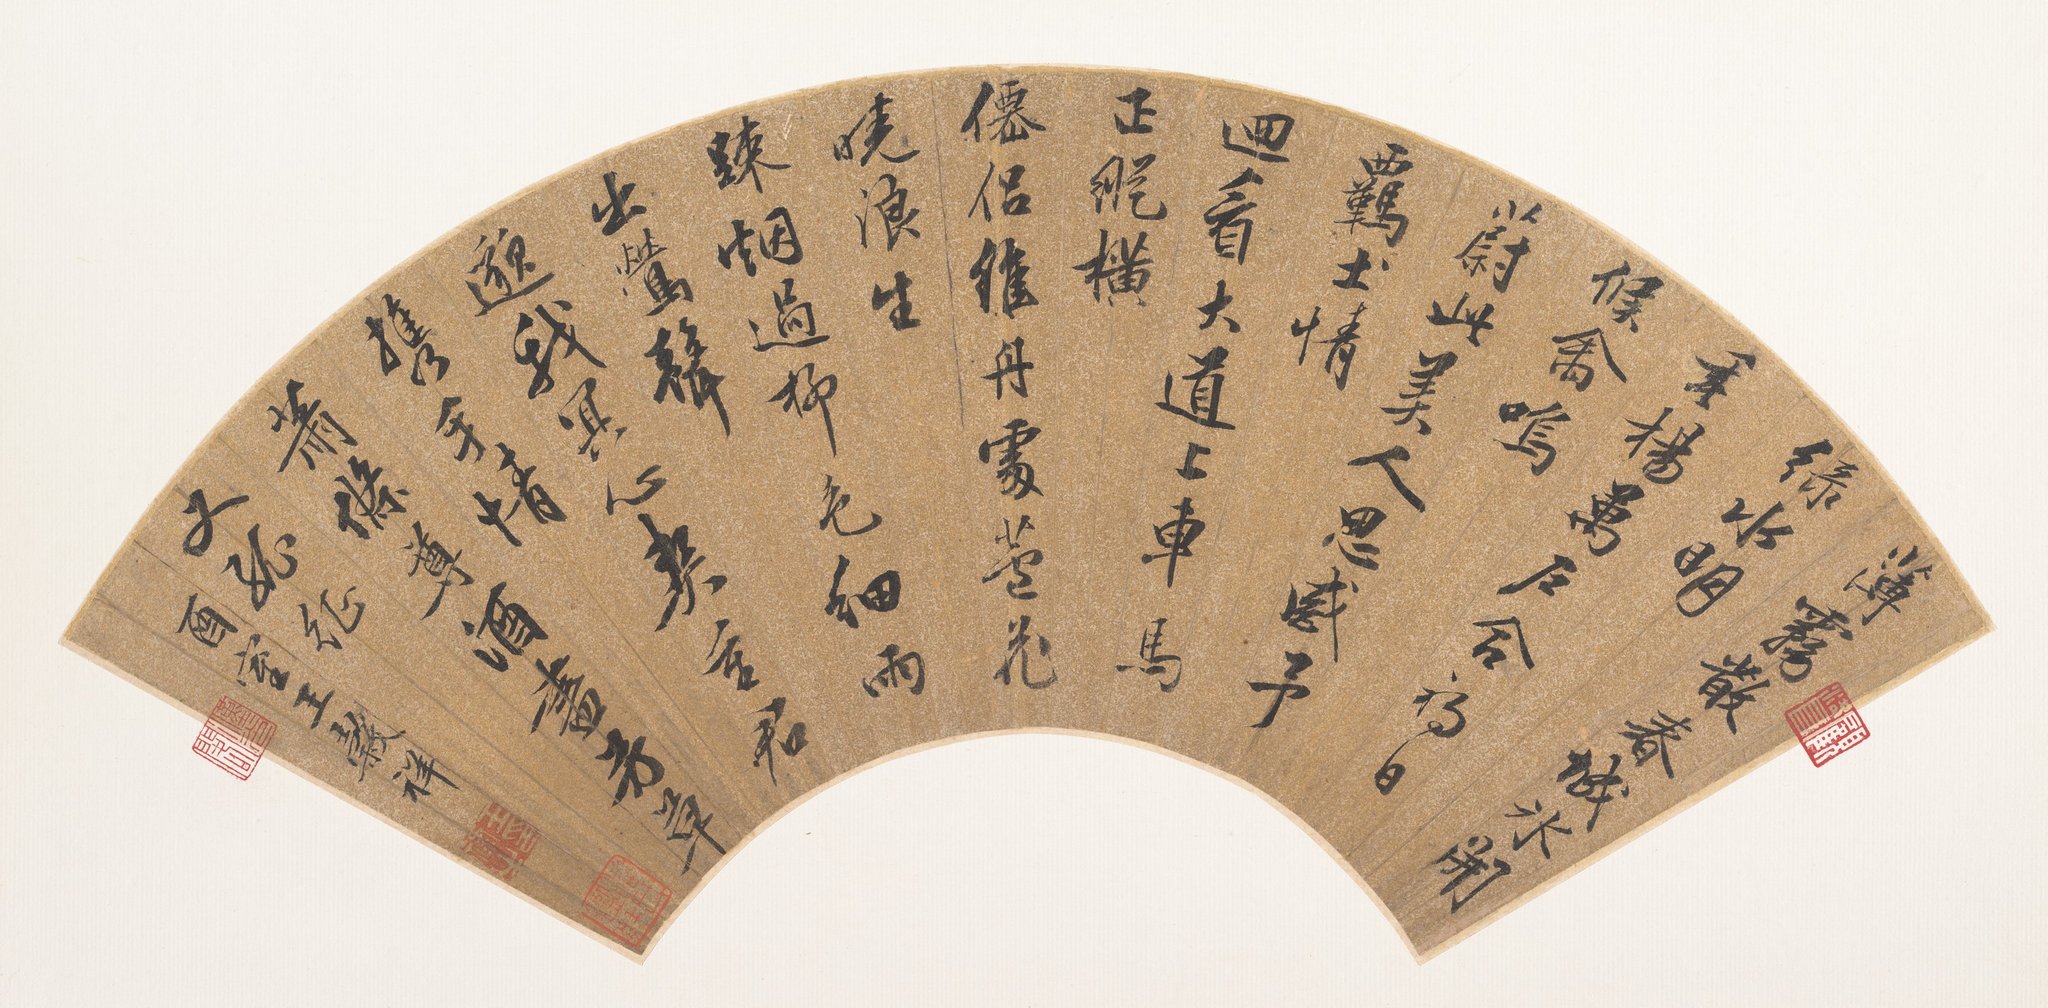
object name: folding fan mounted a an album leaf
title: Two Poems in Five-character Regulated Verse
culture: chinese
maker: wang guxiang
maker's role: artist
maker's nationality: chinese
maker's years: 1501-1568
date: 1501-1568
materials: gold, ink, paper